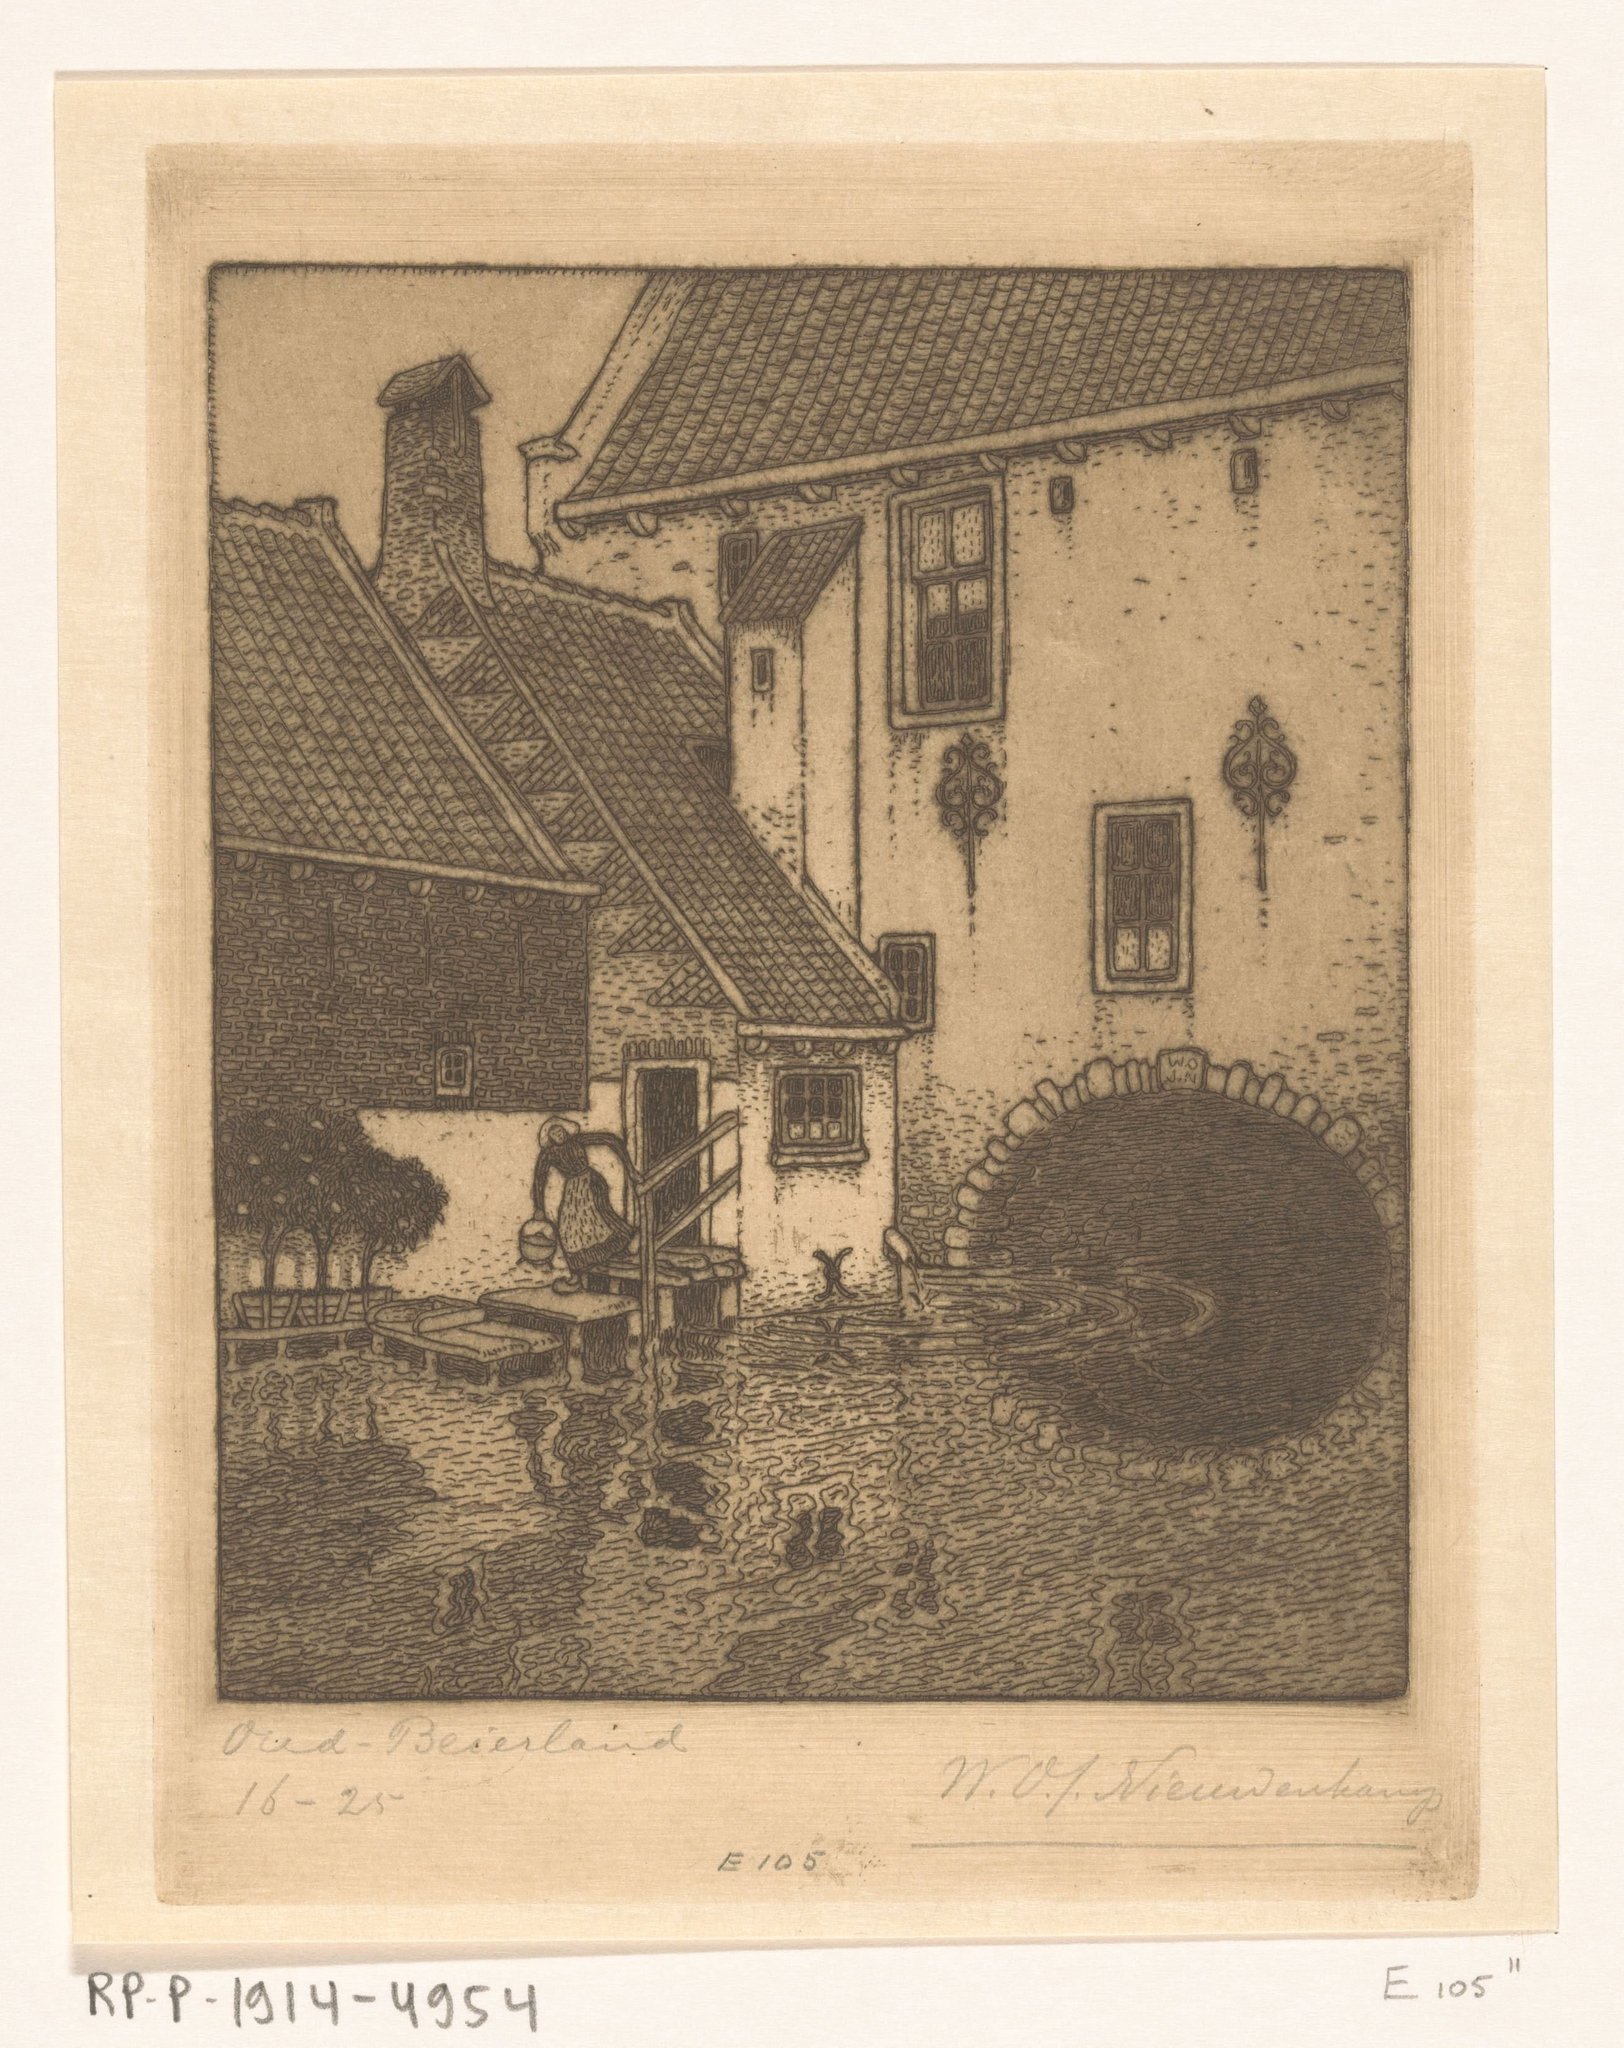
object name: print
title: Achtergevel van het stadhuis in Oud-Beijerland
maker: wijnand otto jan nieuwenkamp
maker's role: draughtsman, print maker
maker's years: 1874-1950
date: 1909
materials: paper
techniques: aquatint, etching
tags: townhall, canals, waters (in city), bridge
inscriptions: collector's mark: Lugt 2233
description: Het stadhuis is gebouwd op een brug over het water. Links een vrouw met een emmer.